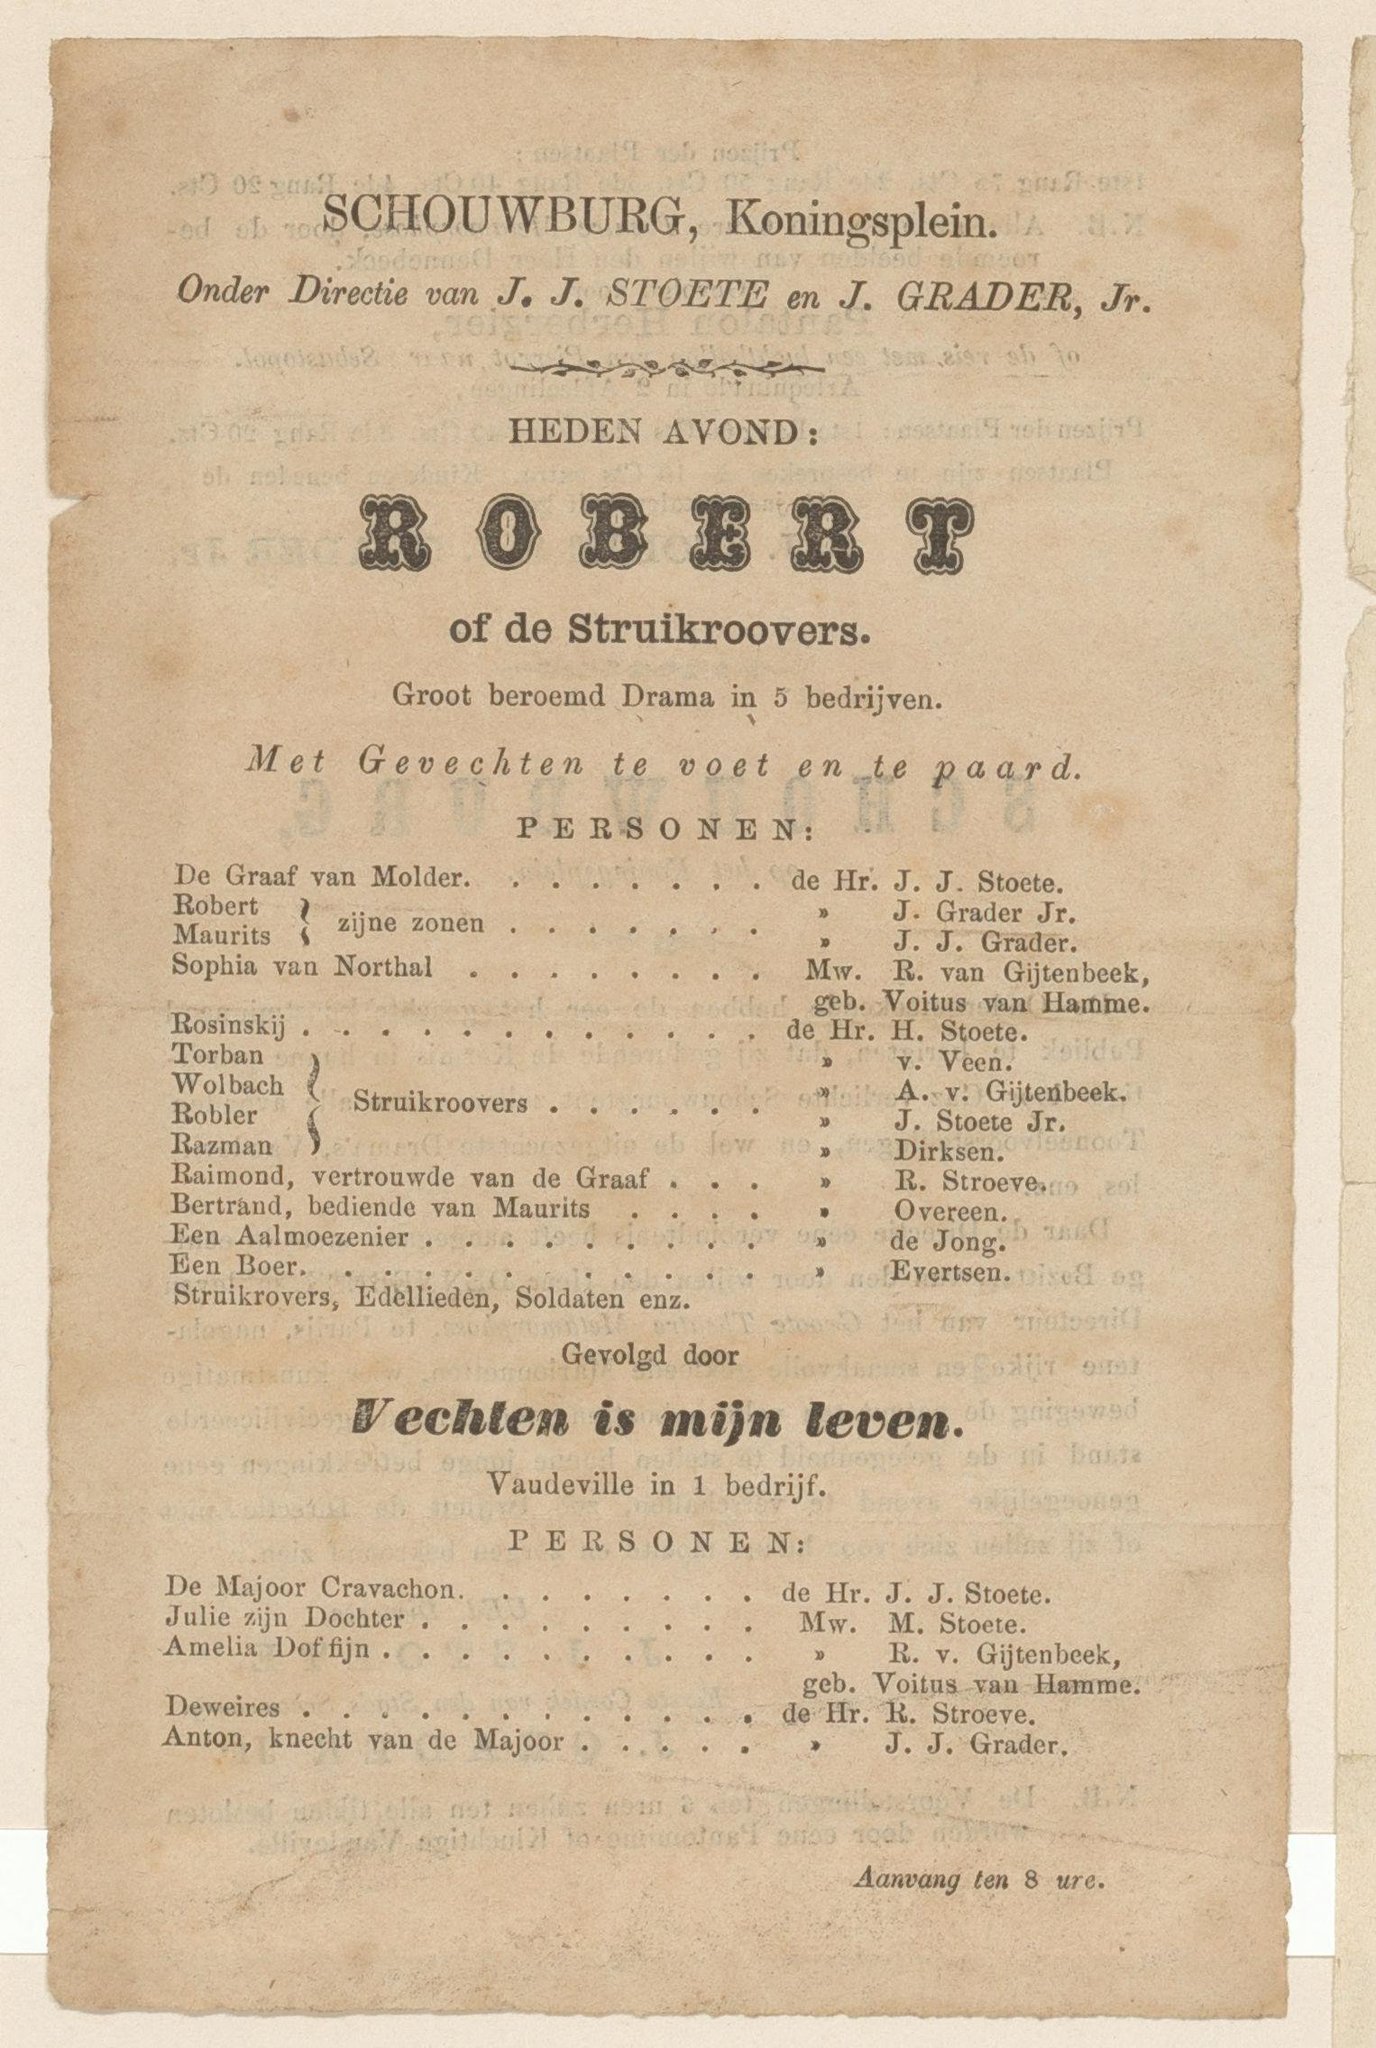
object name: text sheet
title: Aankondiging van de voorstelling Robert of de Struikrovers en Vechten is mijn leven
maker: Anonymous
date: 1850-1869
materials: paper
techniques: letterpress printing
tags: theatre, theatrical performance, art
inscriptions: collector's mark: Lugt 1641, stamp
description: Aankondiging van de voorstelling Robert of de Struikrovers en Vechten is mijn leven. De voorstellingen vinden plaats in de schouwburg op het Koningsplein. Onderwerpsrubrieken binnen de Atlas Zeden en Gewoonten: Tooneel, Toneelprogramma’s.